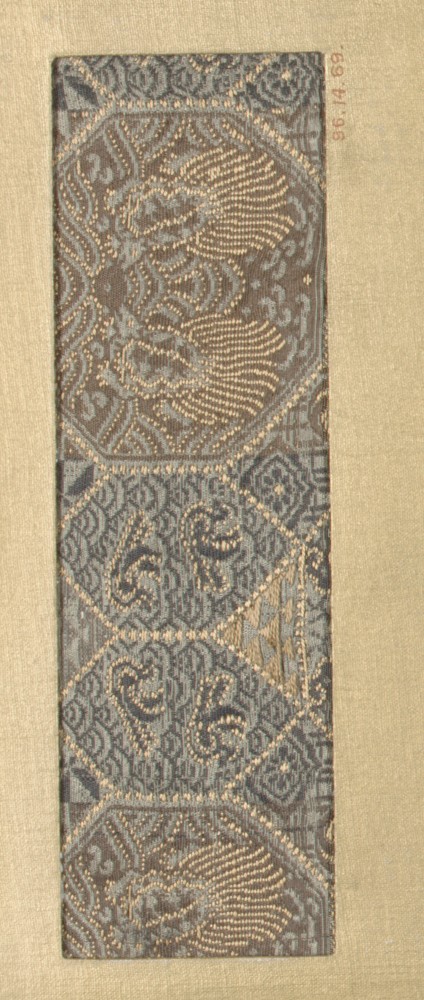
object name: piece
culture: japanese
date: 1701-1900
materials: silk